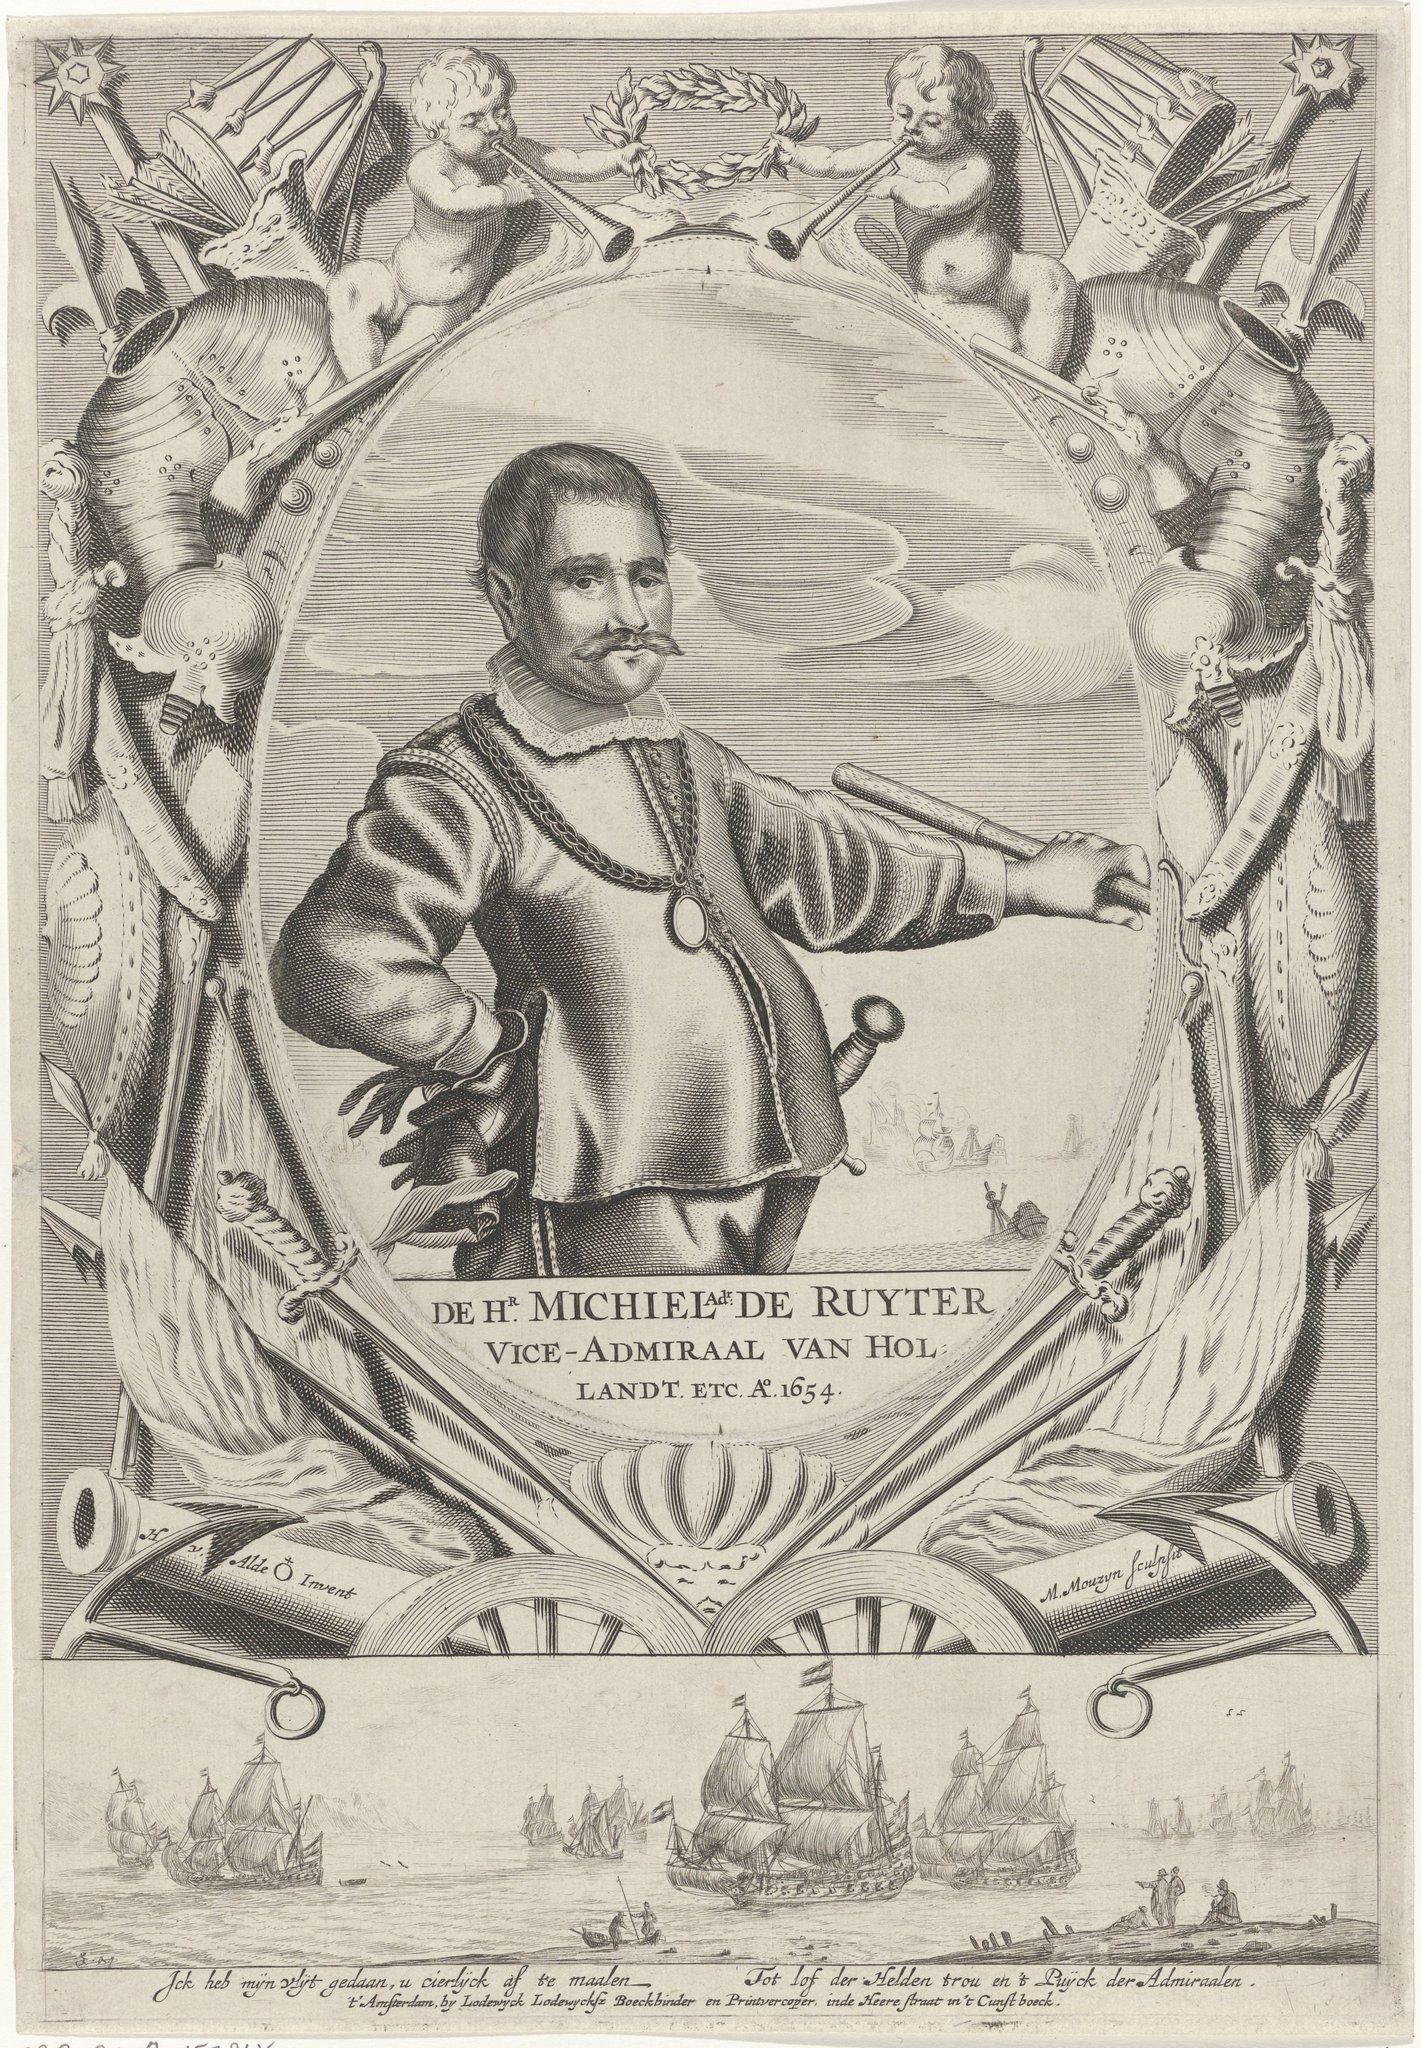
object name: print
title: Portret van Michiel Adriaenszoon de Ruyter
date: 1640-1655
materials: paper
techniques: engraving, etching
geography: amsterdam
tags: flushing, michiel adriaenszoon de ruyter, navy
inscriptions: collector's mark: Lugt 2228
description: Portret van admiraal Michiel Adriaenszoon de Ruyter, in zijn hand de bevelhebberstaf. Het portret is gevat in ornamentele lijst met vlaggen, zwaarden, kanonnen, harnasdelen en wordt bekroond door twee putti, die een lauwerkrans ophouden. Onderaan in de marge een zeegezicht met zeilschepen.